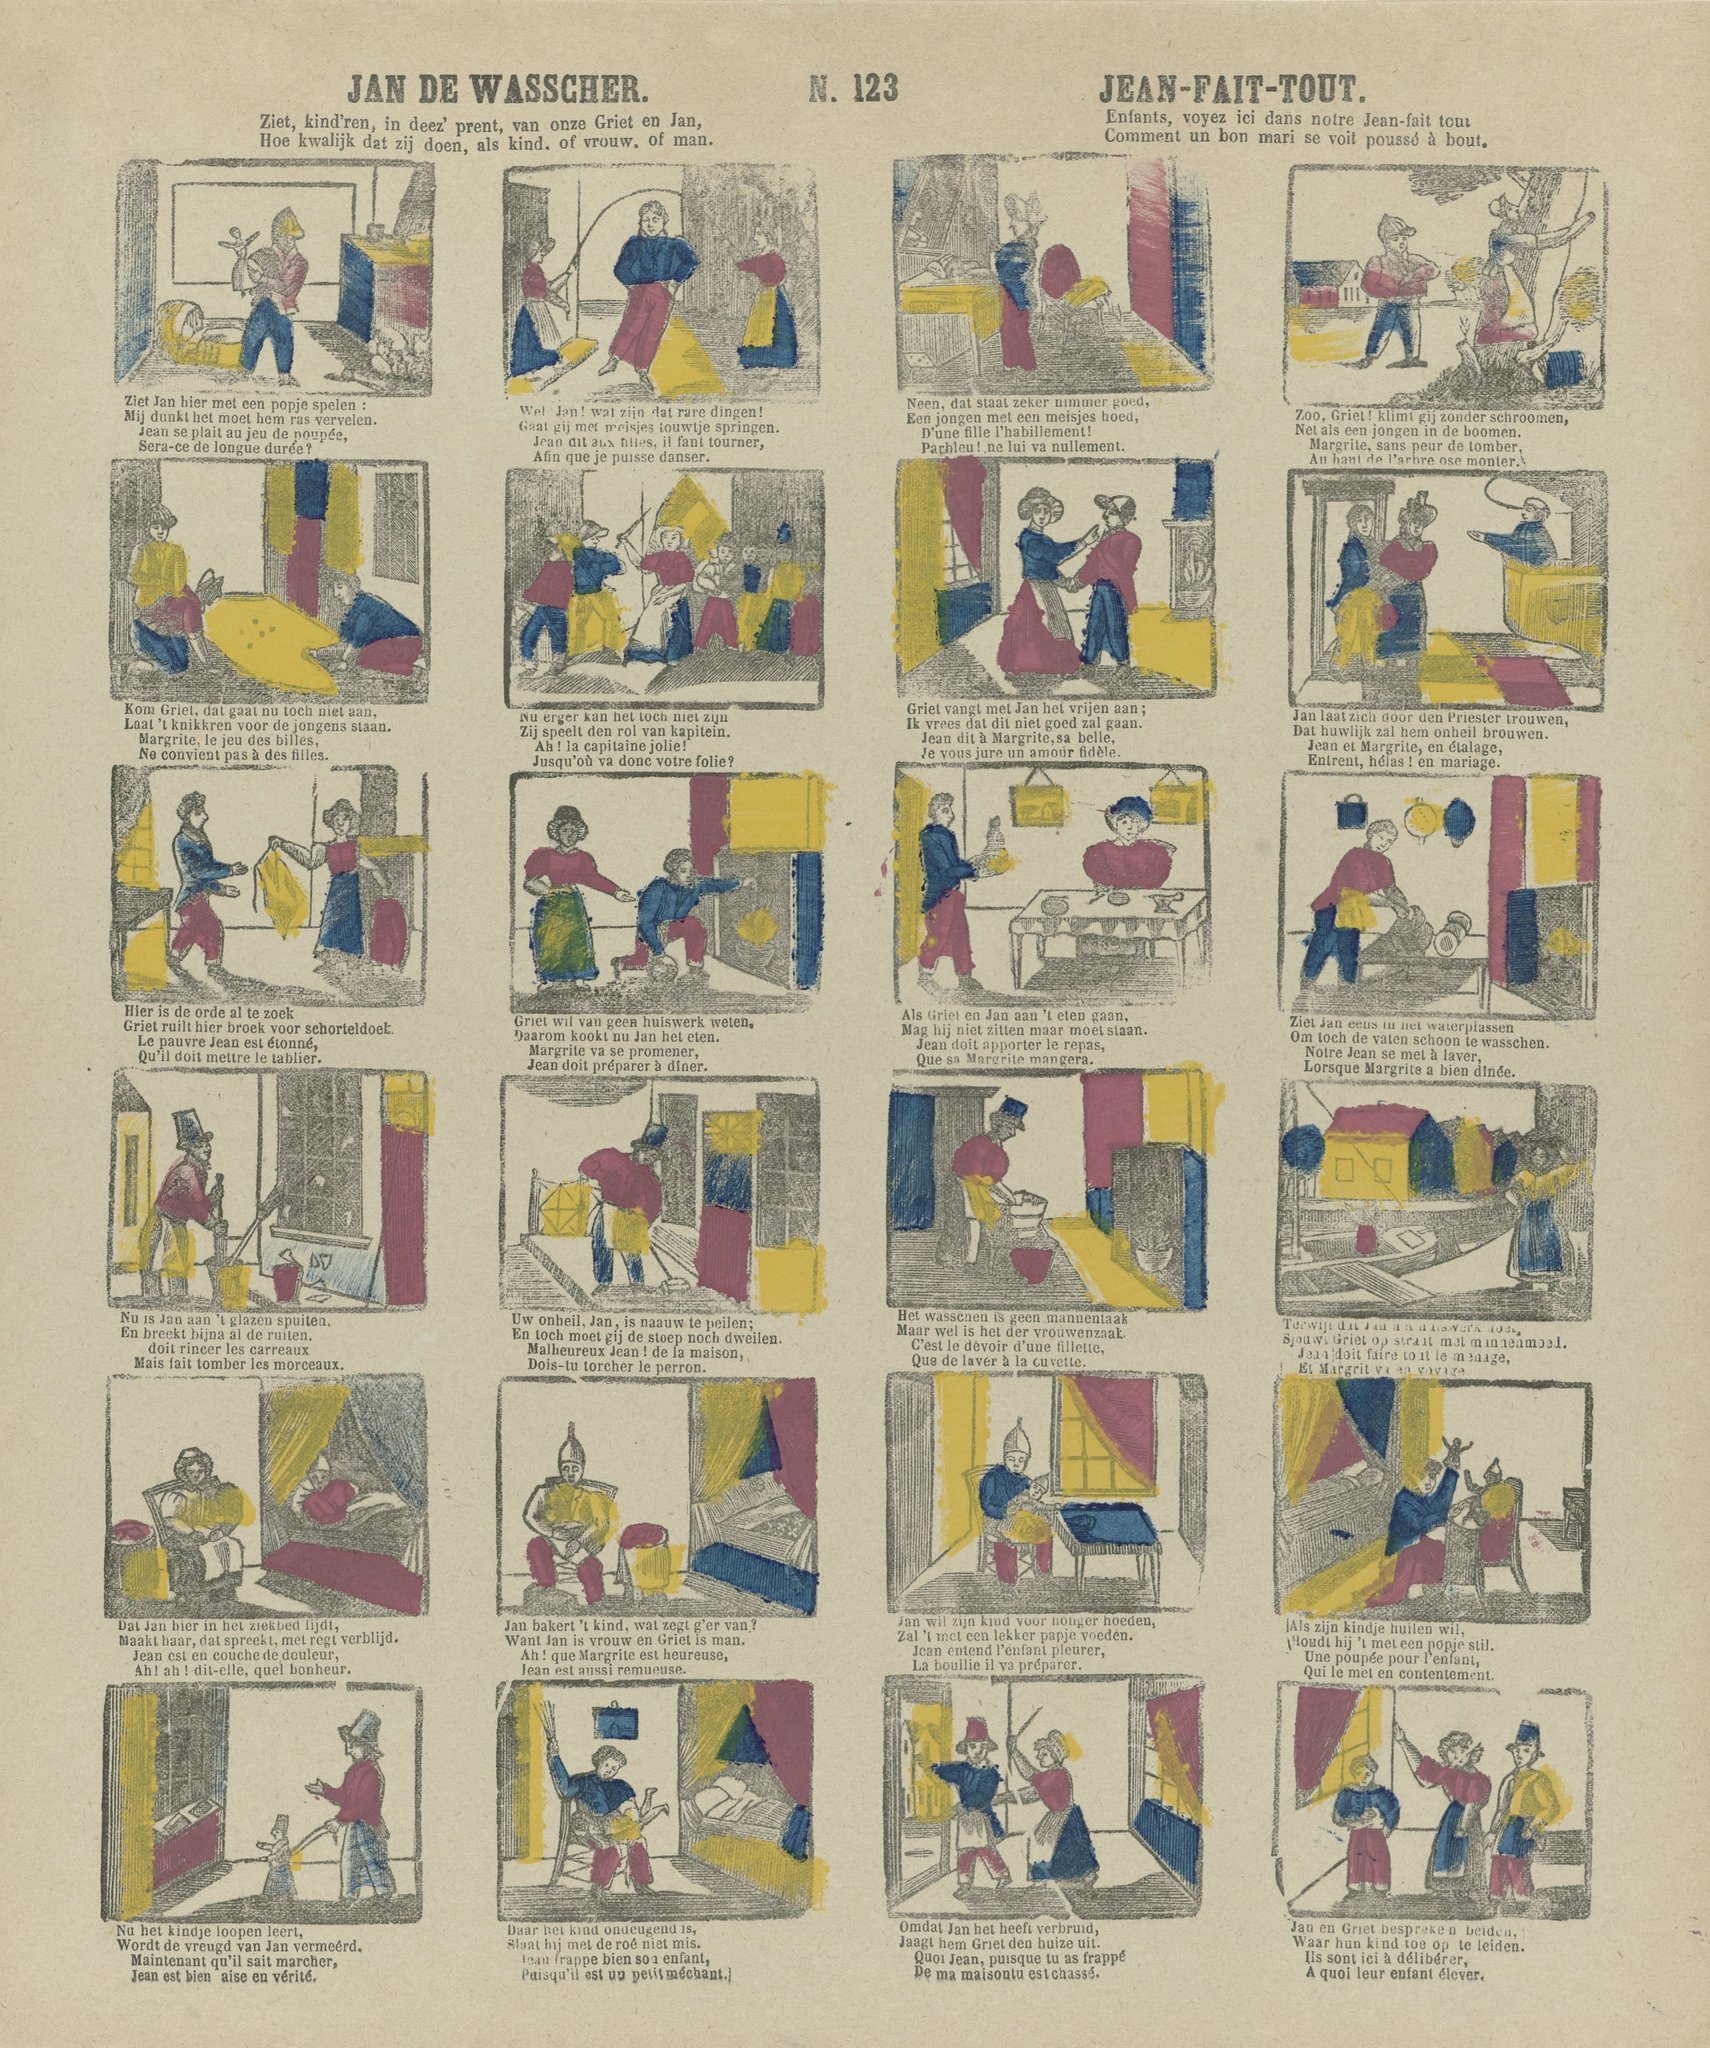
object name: popular print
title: Jan de Wasscher / Jean-fait-tout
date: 1800-1833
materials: paper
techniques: colour, letterpress printing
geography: turnhout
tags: hen-pecked husband, 'betty', 'molly' (man who engages in women's work)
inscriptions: collector's mark: Lugt 2760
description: Blad met 24 voorstellingen uit het leven van Jan de Wasser, een man die van zijn vrouw Griet, die de broek aan heeft, al het huishoudelijk werk moet doen. Onder elke voorstelling een tweeregelig vers in het Nederlands en in het Frans. Genummerd midden boven: N. 123.